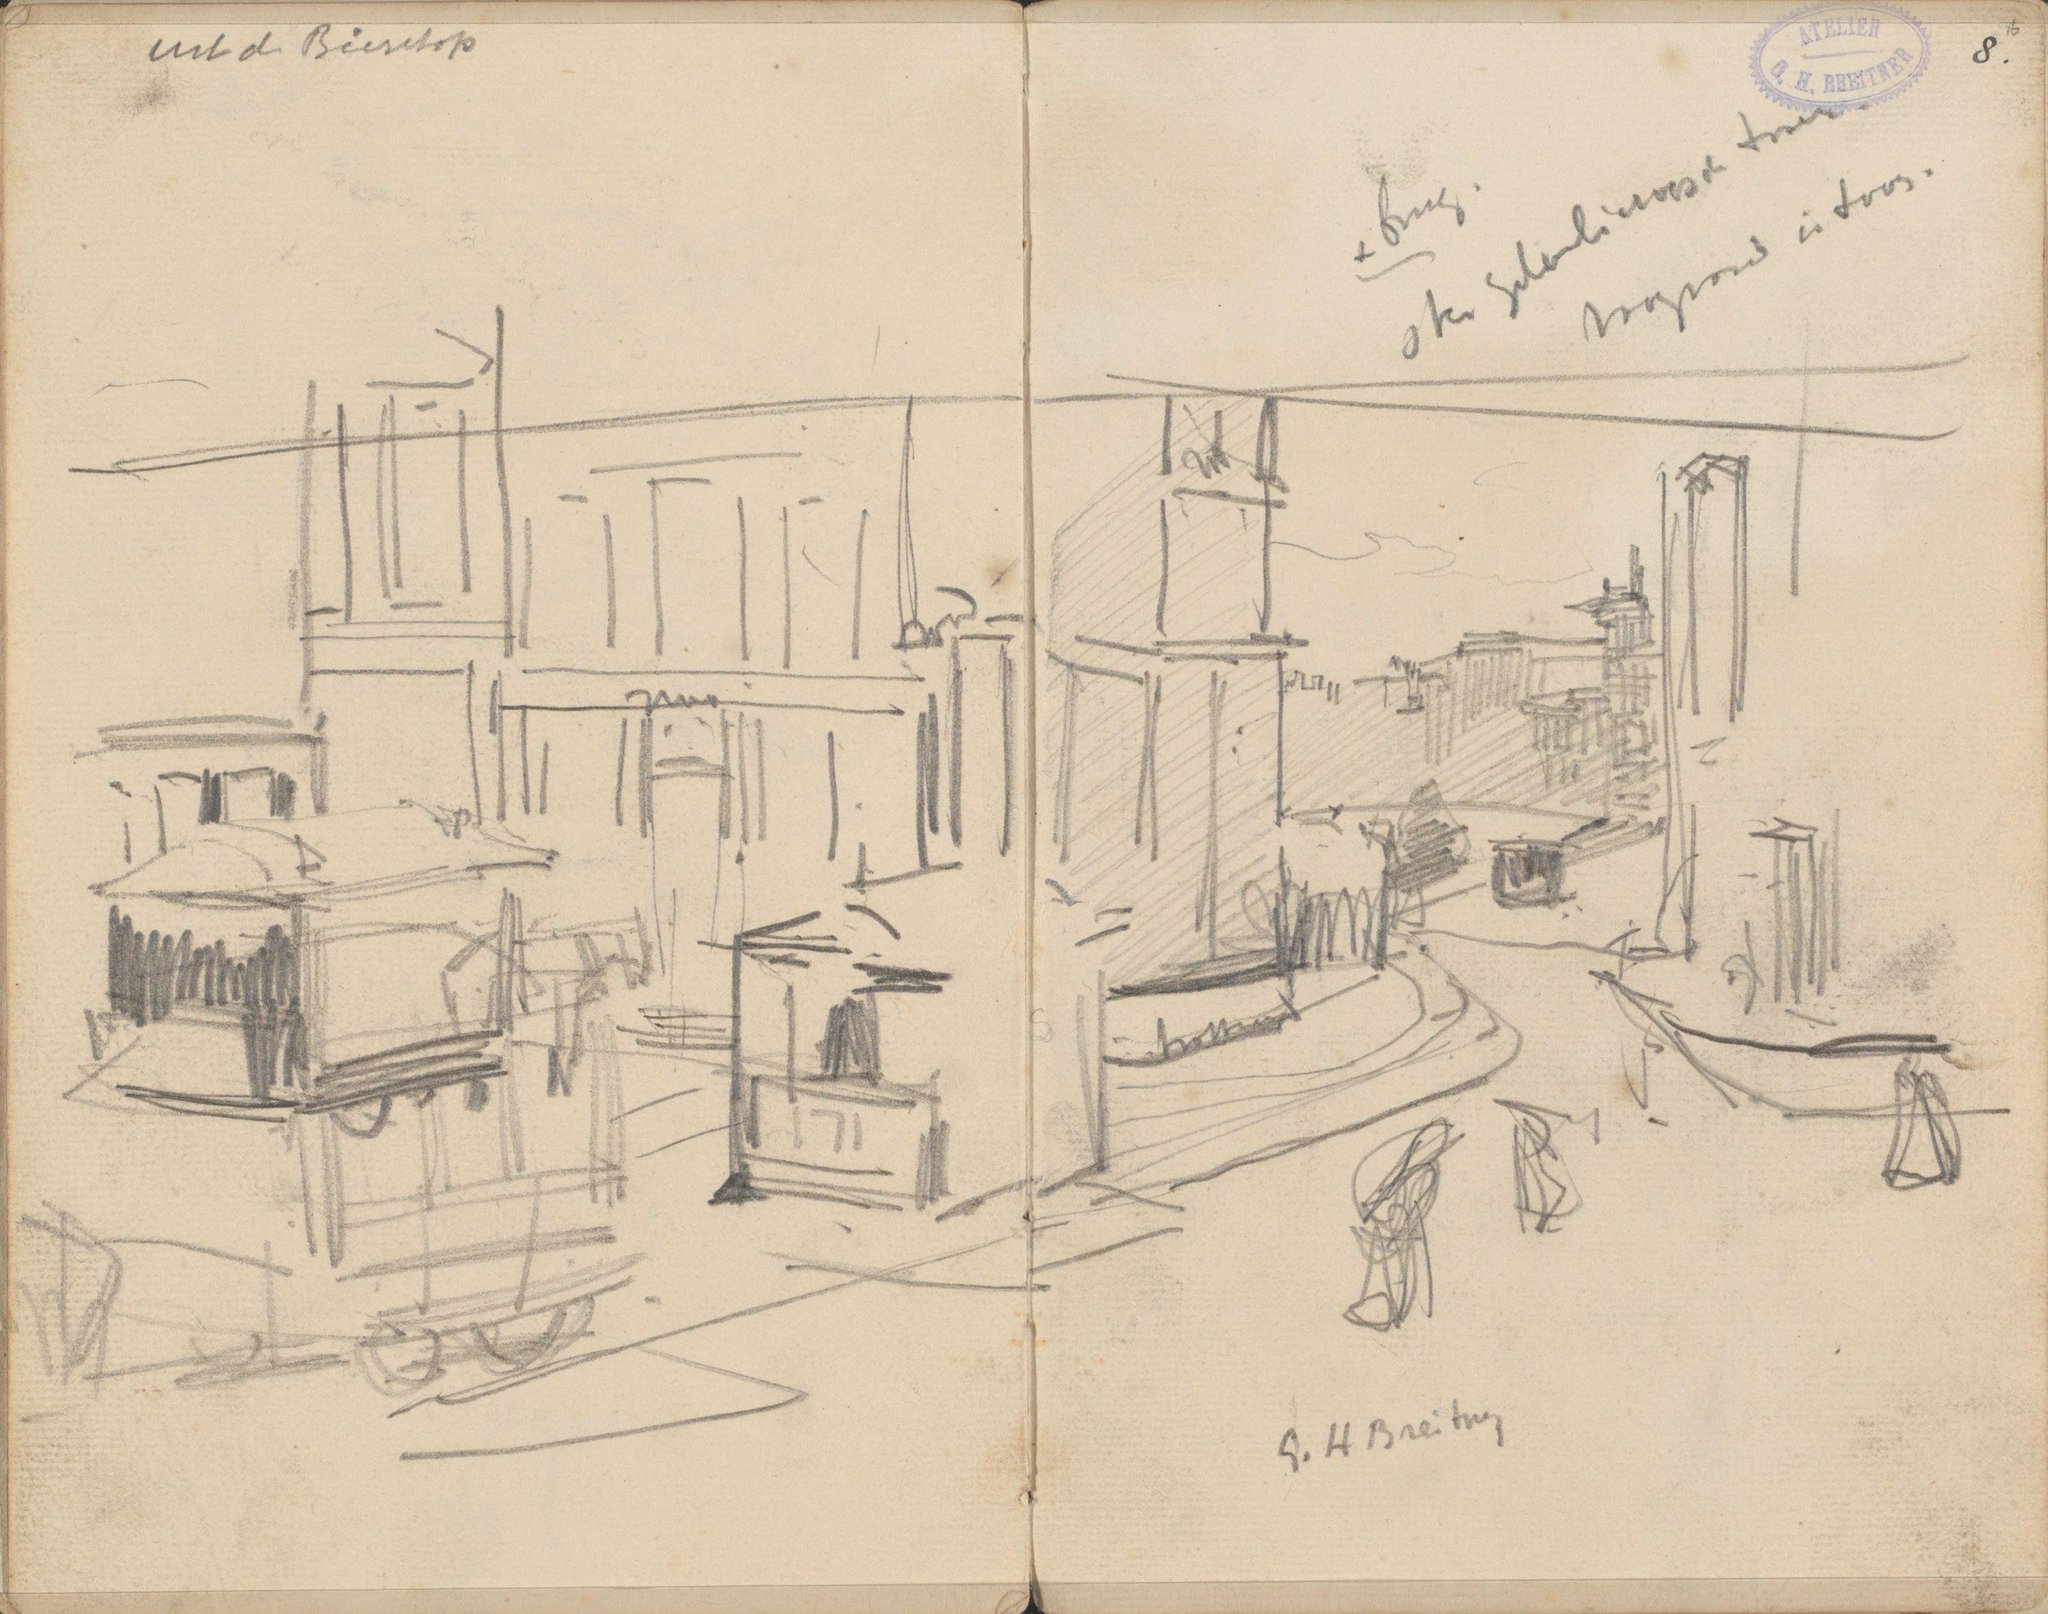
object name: sketchbook leaf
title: Dam te Amsterdam, gezien vanuit café Bisschop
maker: george hendrik breitner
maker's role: draughtsman, painter, print maker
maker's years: 1857-1923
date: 1889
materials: paper, pencil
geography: amsterdam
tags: square, place, circus, etc. (+ city(-scape) with figures, staffage)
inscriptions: signature: ‘G.H. Breitner’, annotation: ‘uit de Bisschop/ +brug/’, workshop stamp: Lugt 291d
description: Pagina 15 en pagina 16 uit een schetsboek met 14 bladen.